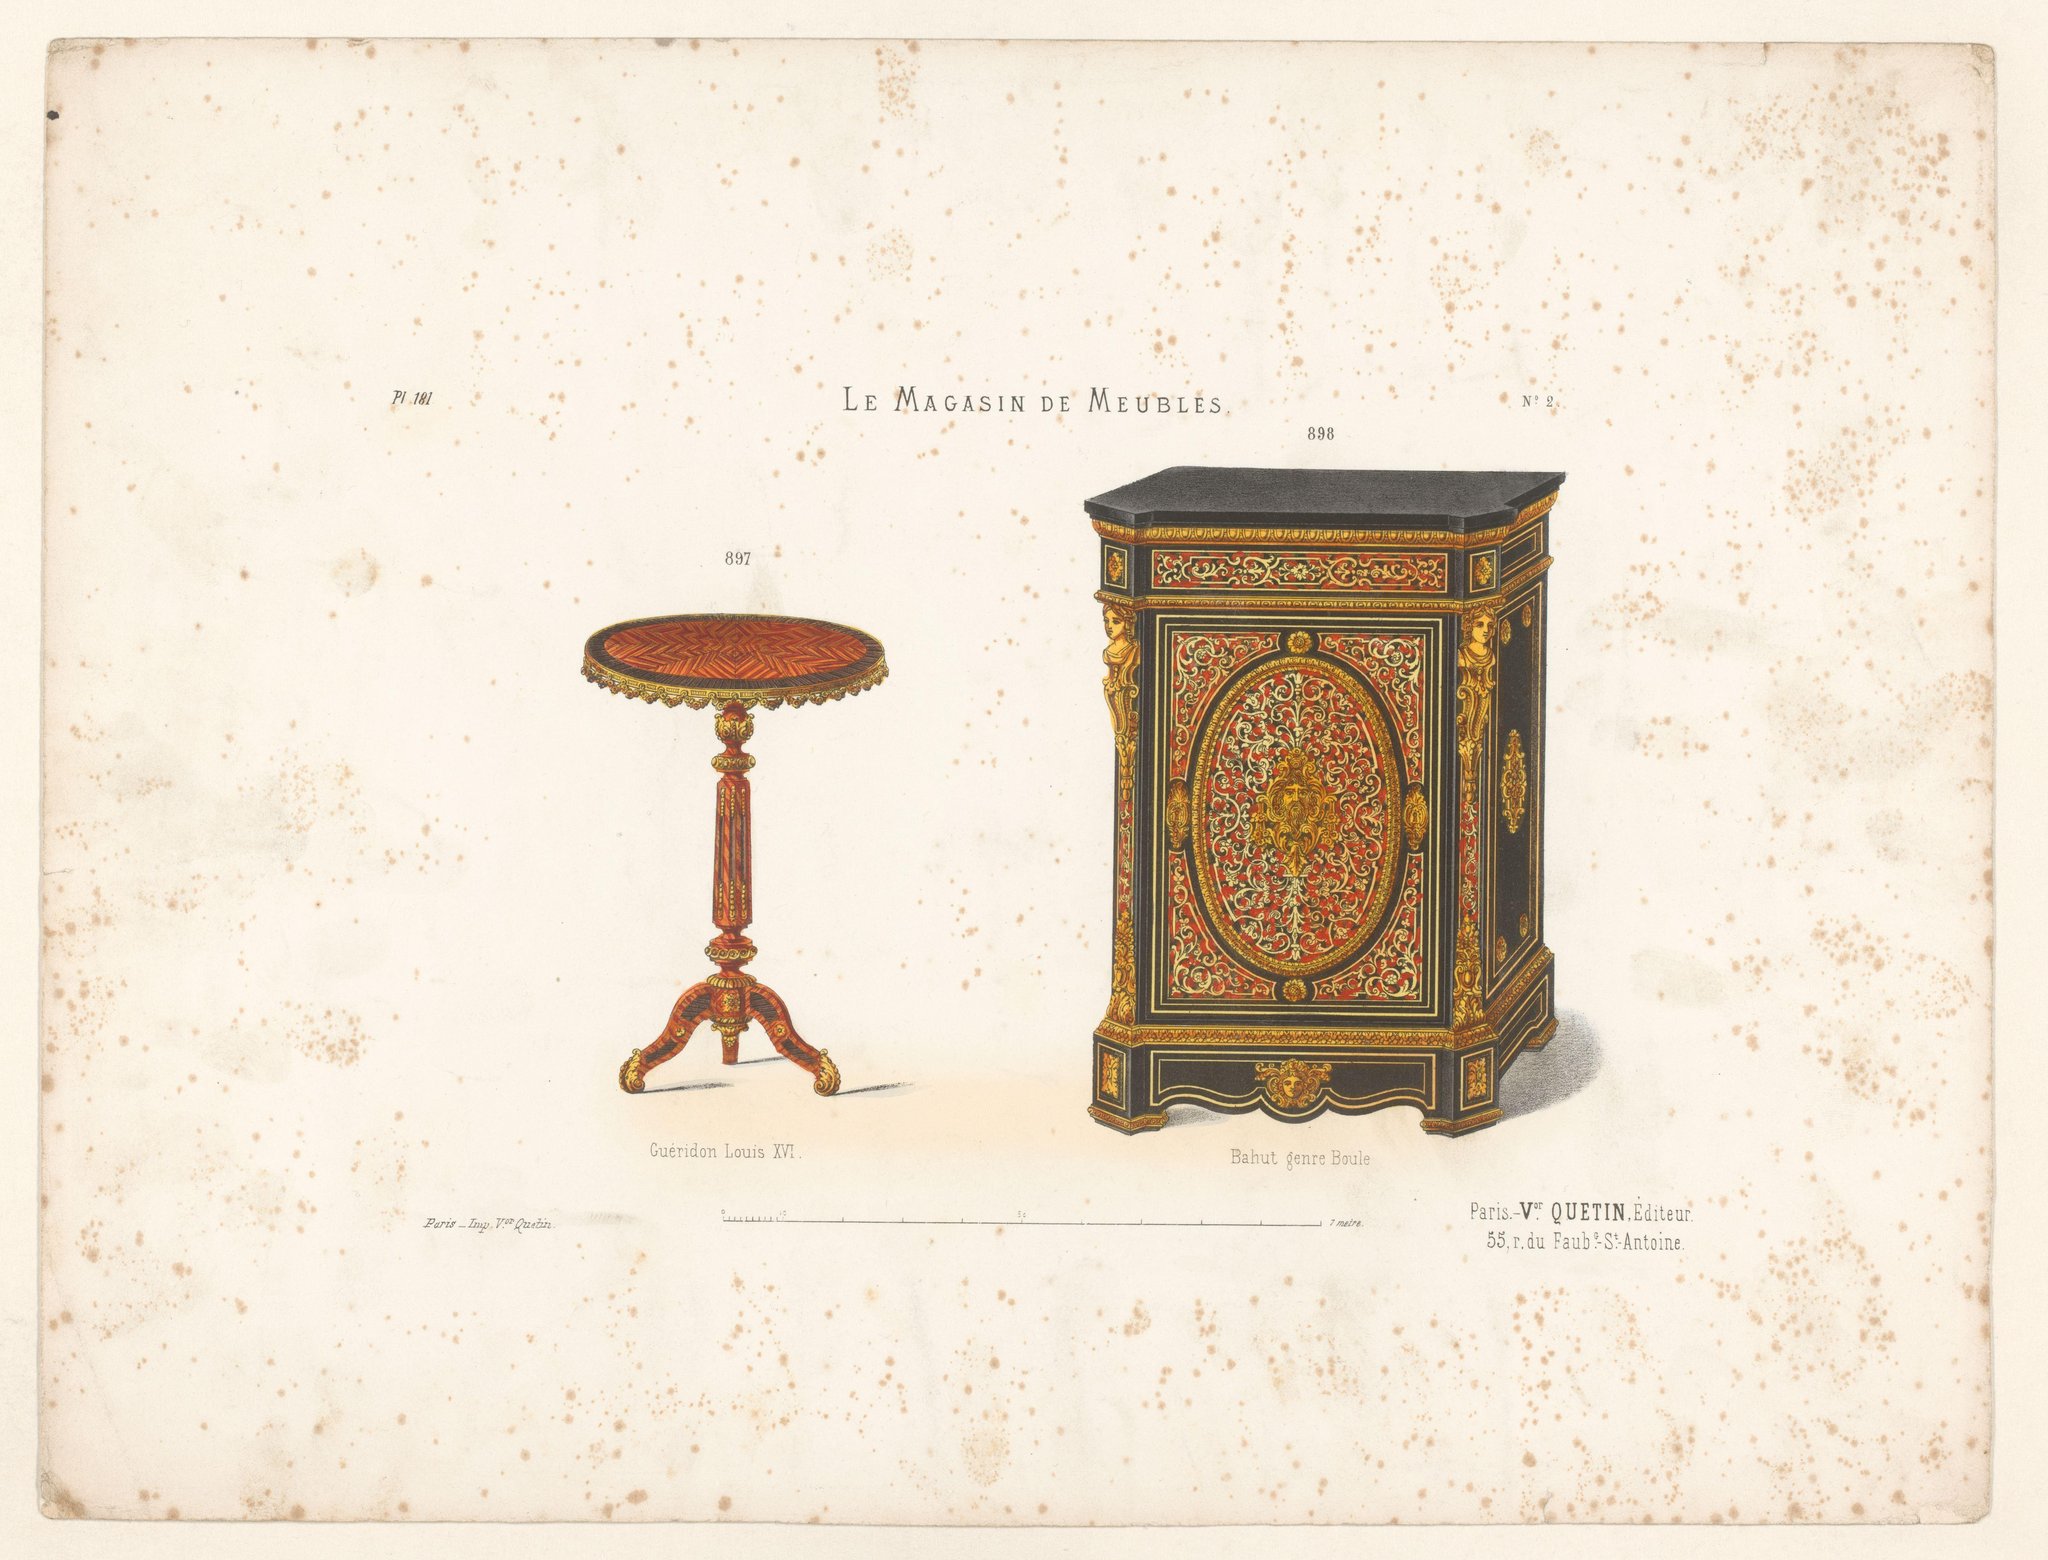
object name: print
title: Gueridon en kast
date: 1832-1877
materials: paper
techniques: hand coloring, lithograph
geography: paris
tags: furniture for storage, table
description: Een gueridon in de Lodewijk XVI-stijl en een lage kast.